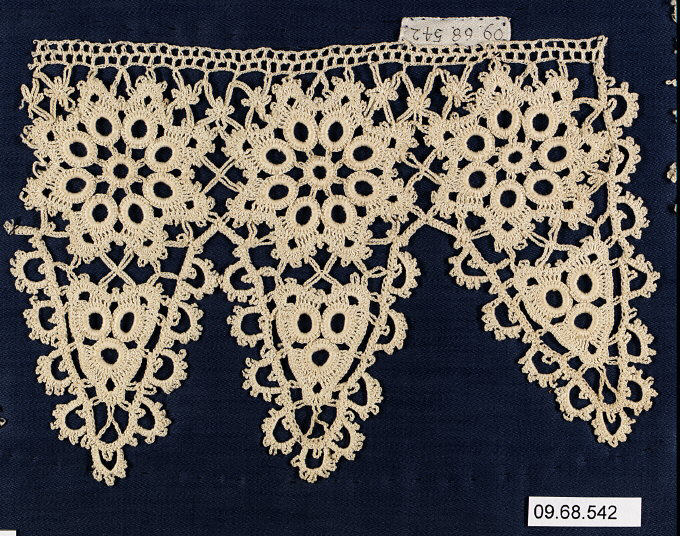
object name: piece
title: Piece (one of two)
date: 1801-1900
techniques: crochet